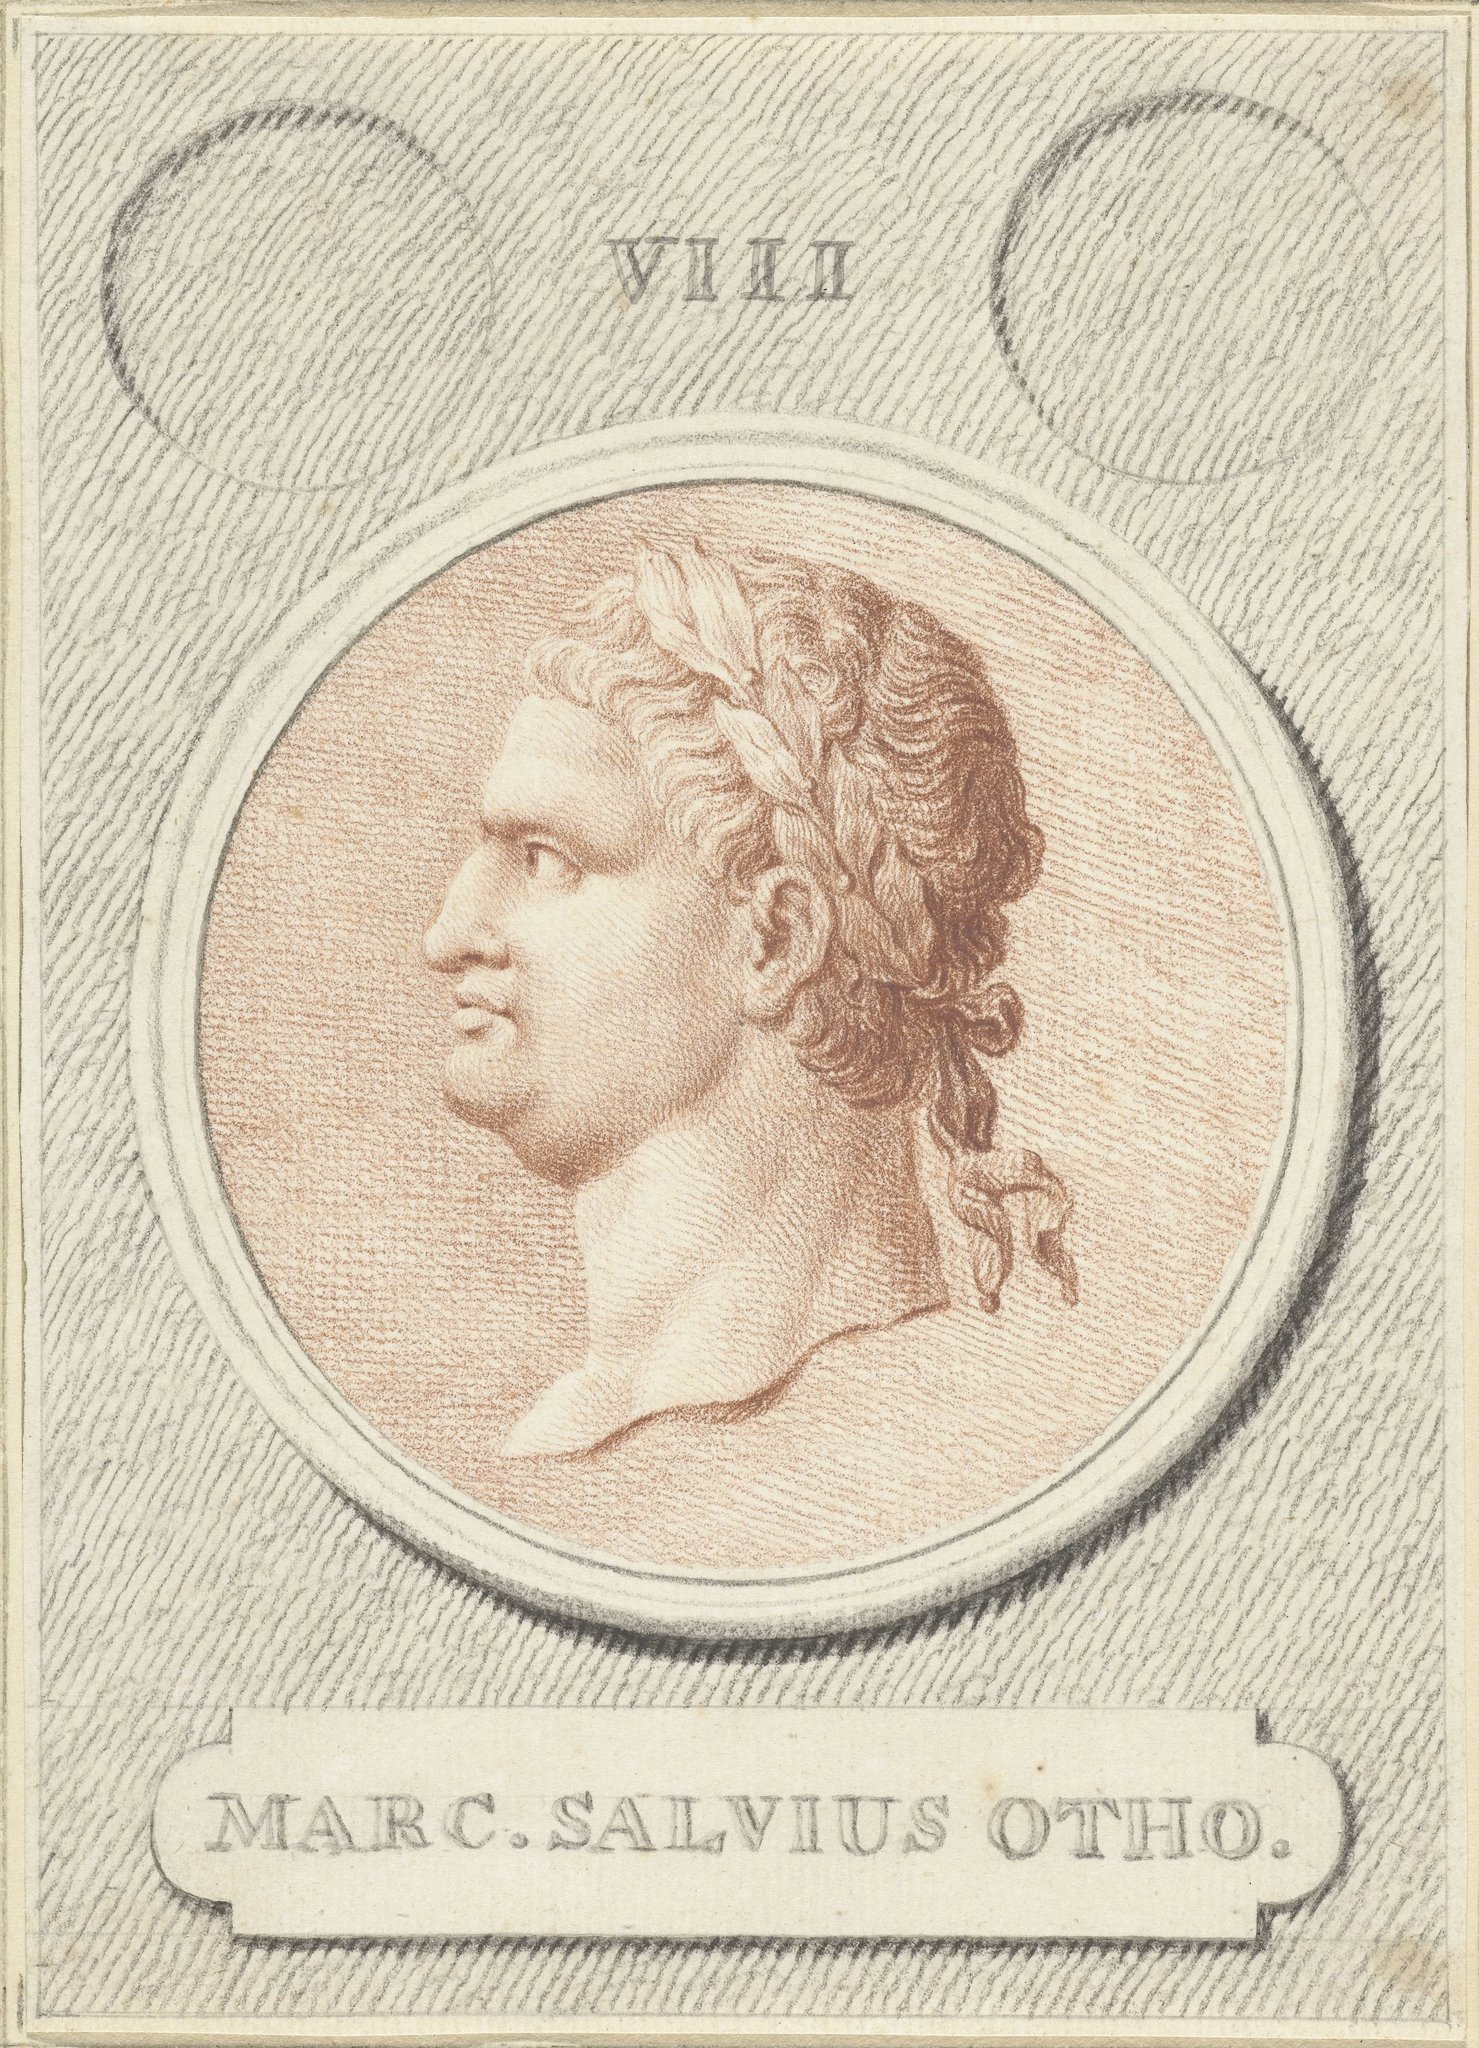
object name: design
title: Portretmedaillon van Otho, Romeins keizer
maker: jan caspar philips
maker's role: draughtsman, print maker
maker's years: 1700-1775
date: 1736-1775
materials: chalk, ink, paper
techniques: brush, pen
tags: male persons from classical history (otho) - portrait of person from classical history, historical persons